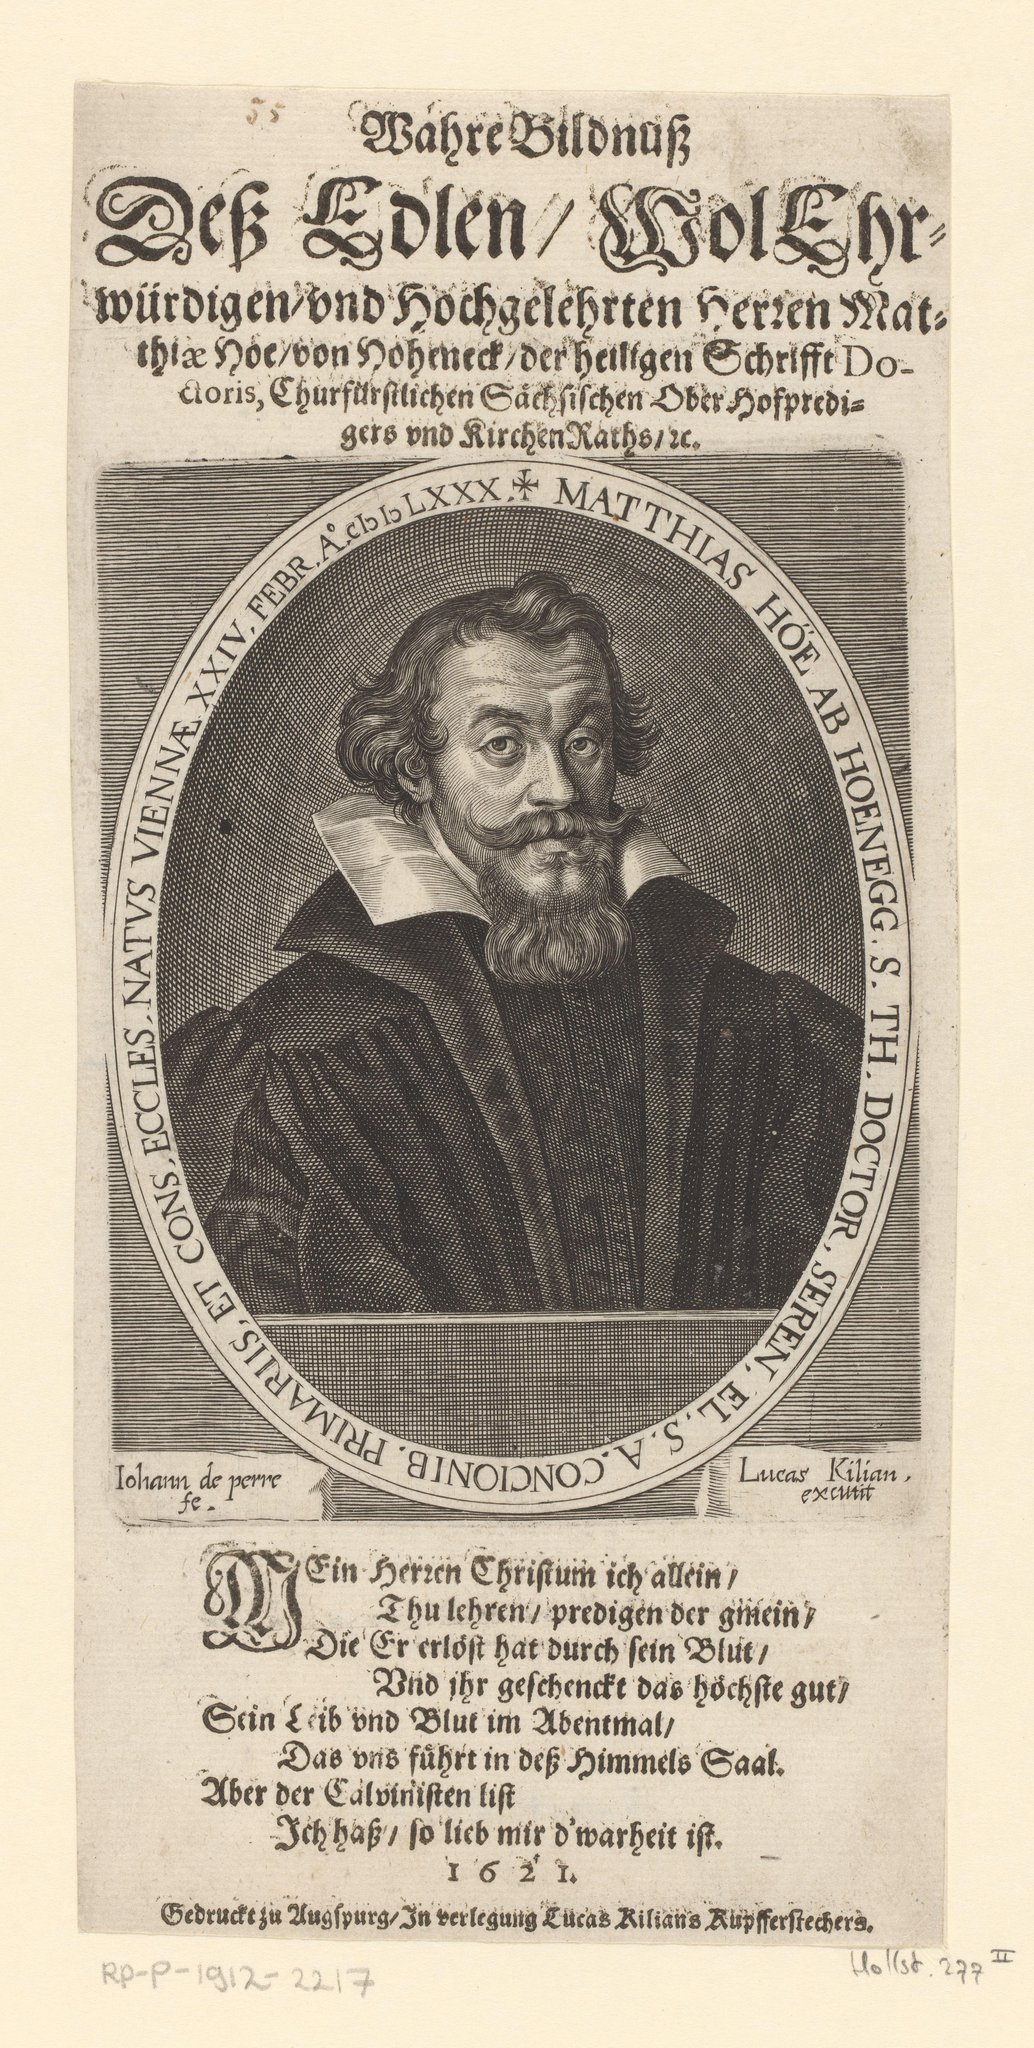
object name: print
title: Portret van Matthias Hoë van Hoënegg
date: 1621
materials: paper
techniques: engraving, letterpress printing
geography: augsburg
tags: vienna, theologian, historical persons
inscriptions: collector's mark: Lugt 2228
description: Tekst in het Latijn in de omlijsting en tekst in het Duits in boekdruk op het blad.